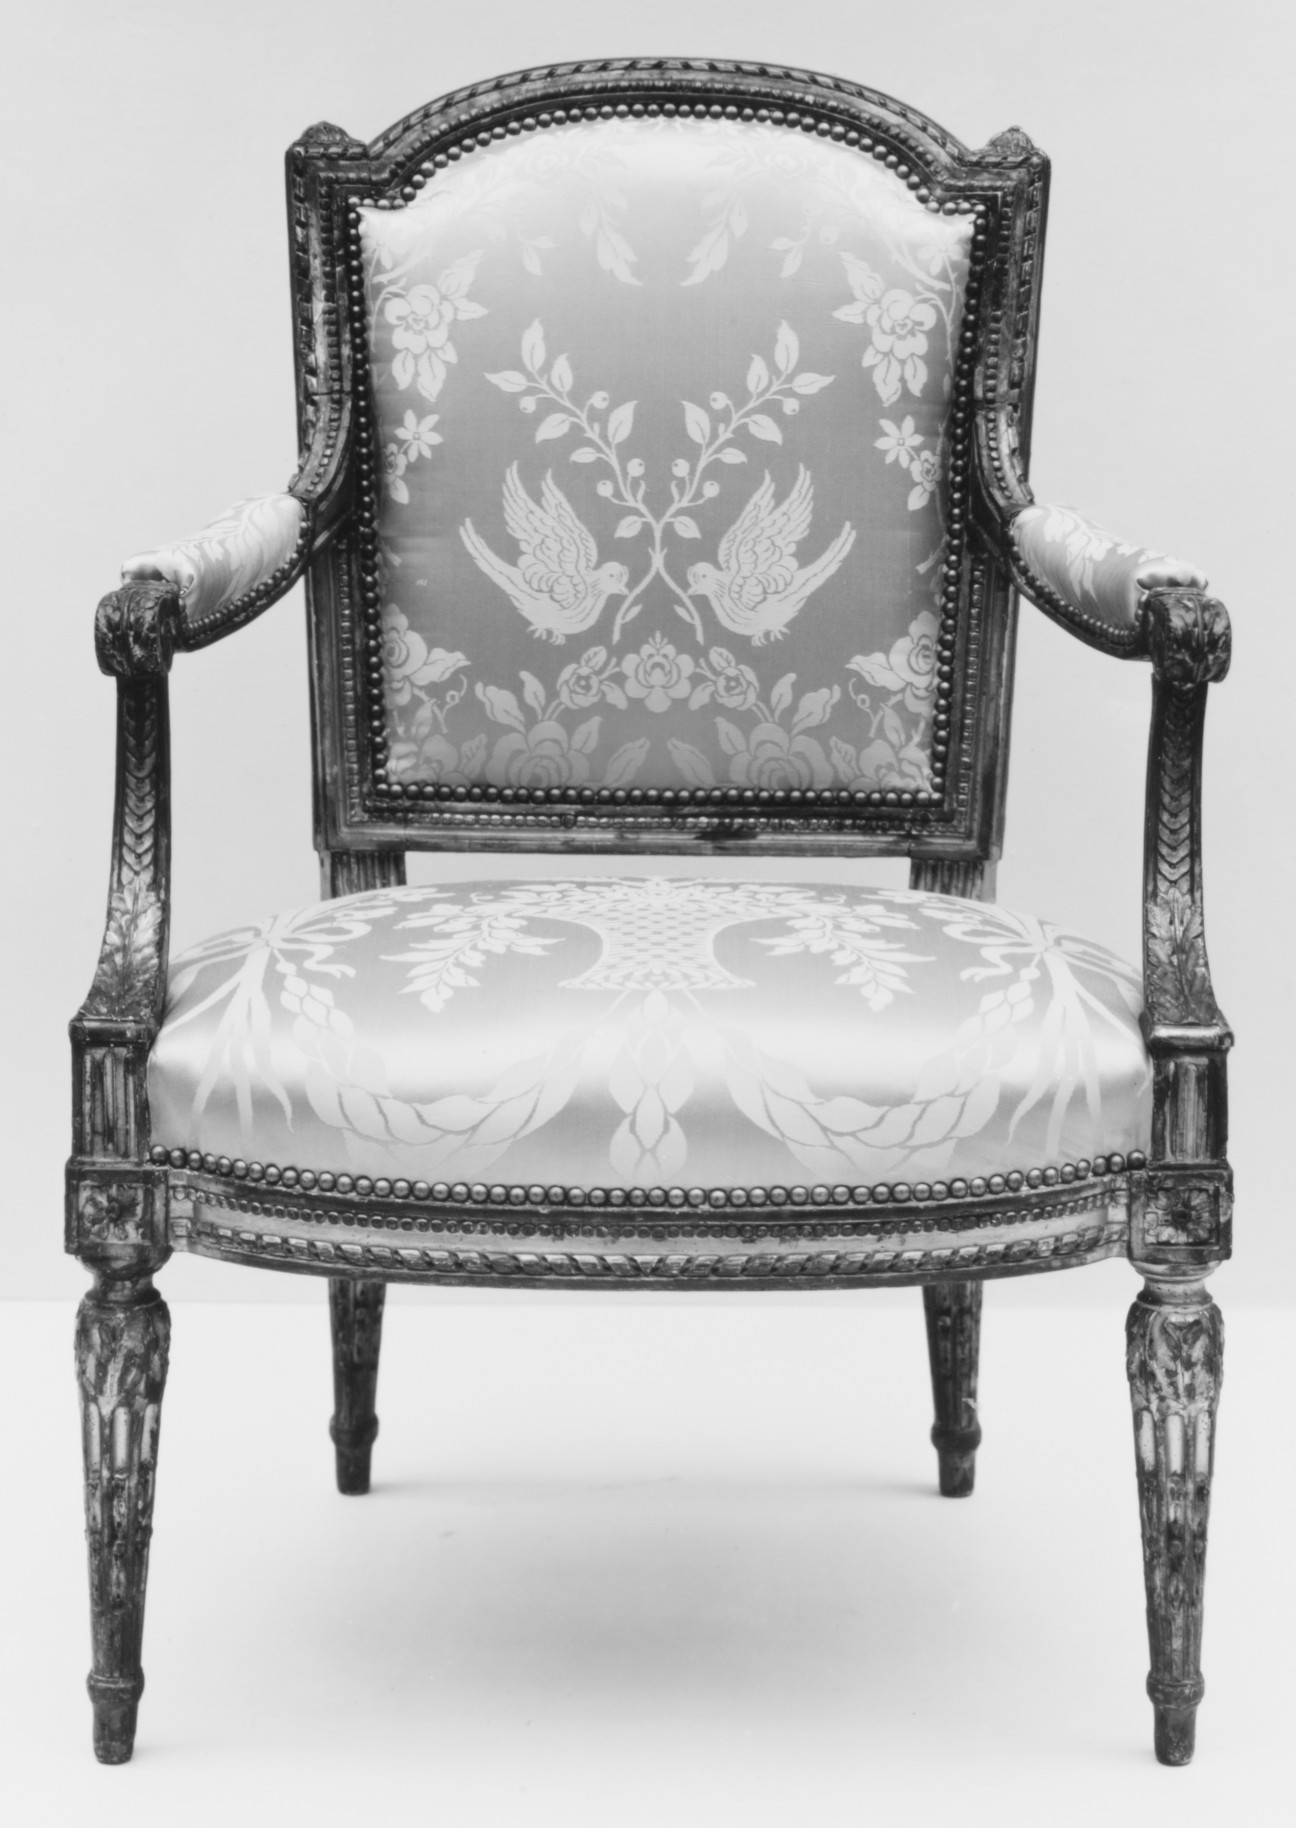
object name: armchair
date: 1780-1790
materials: wood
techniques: carving, gilding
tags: birds,flowers